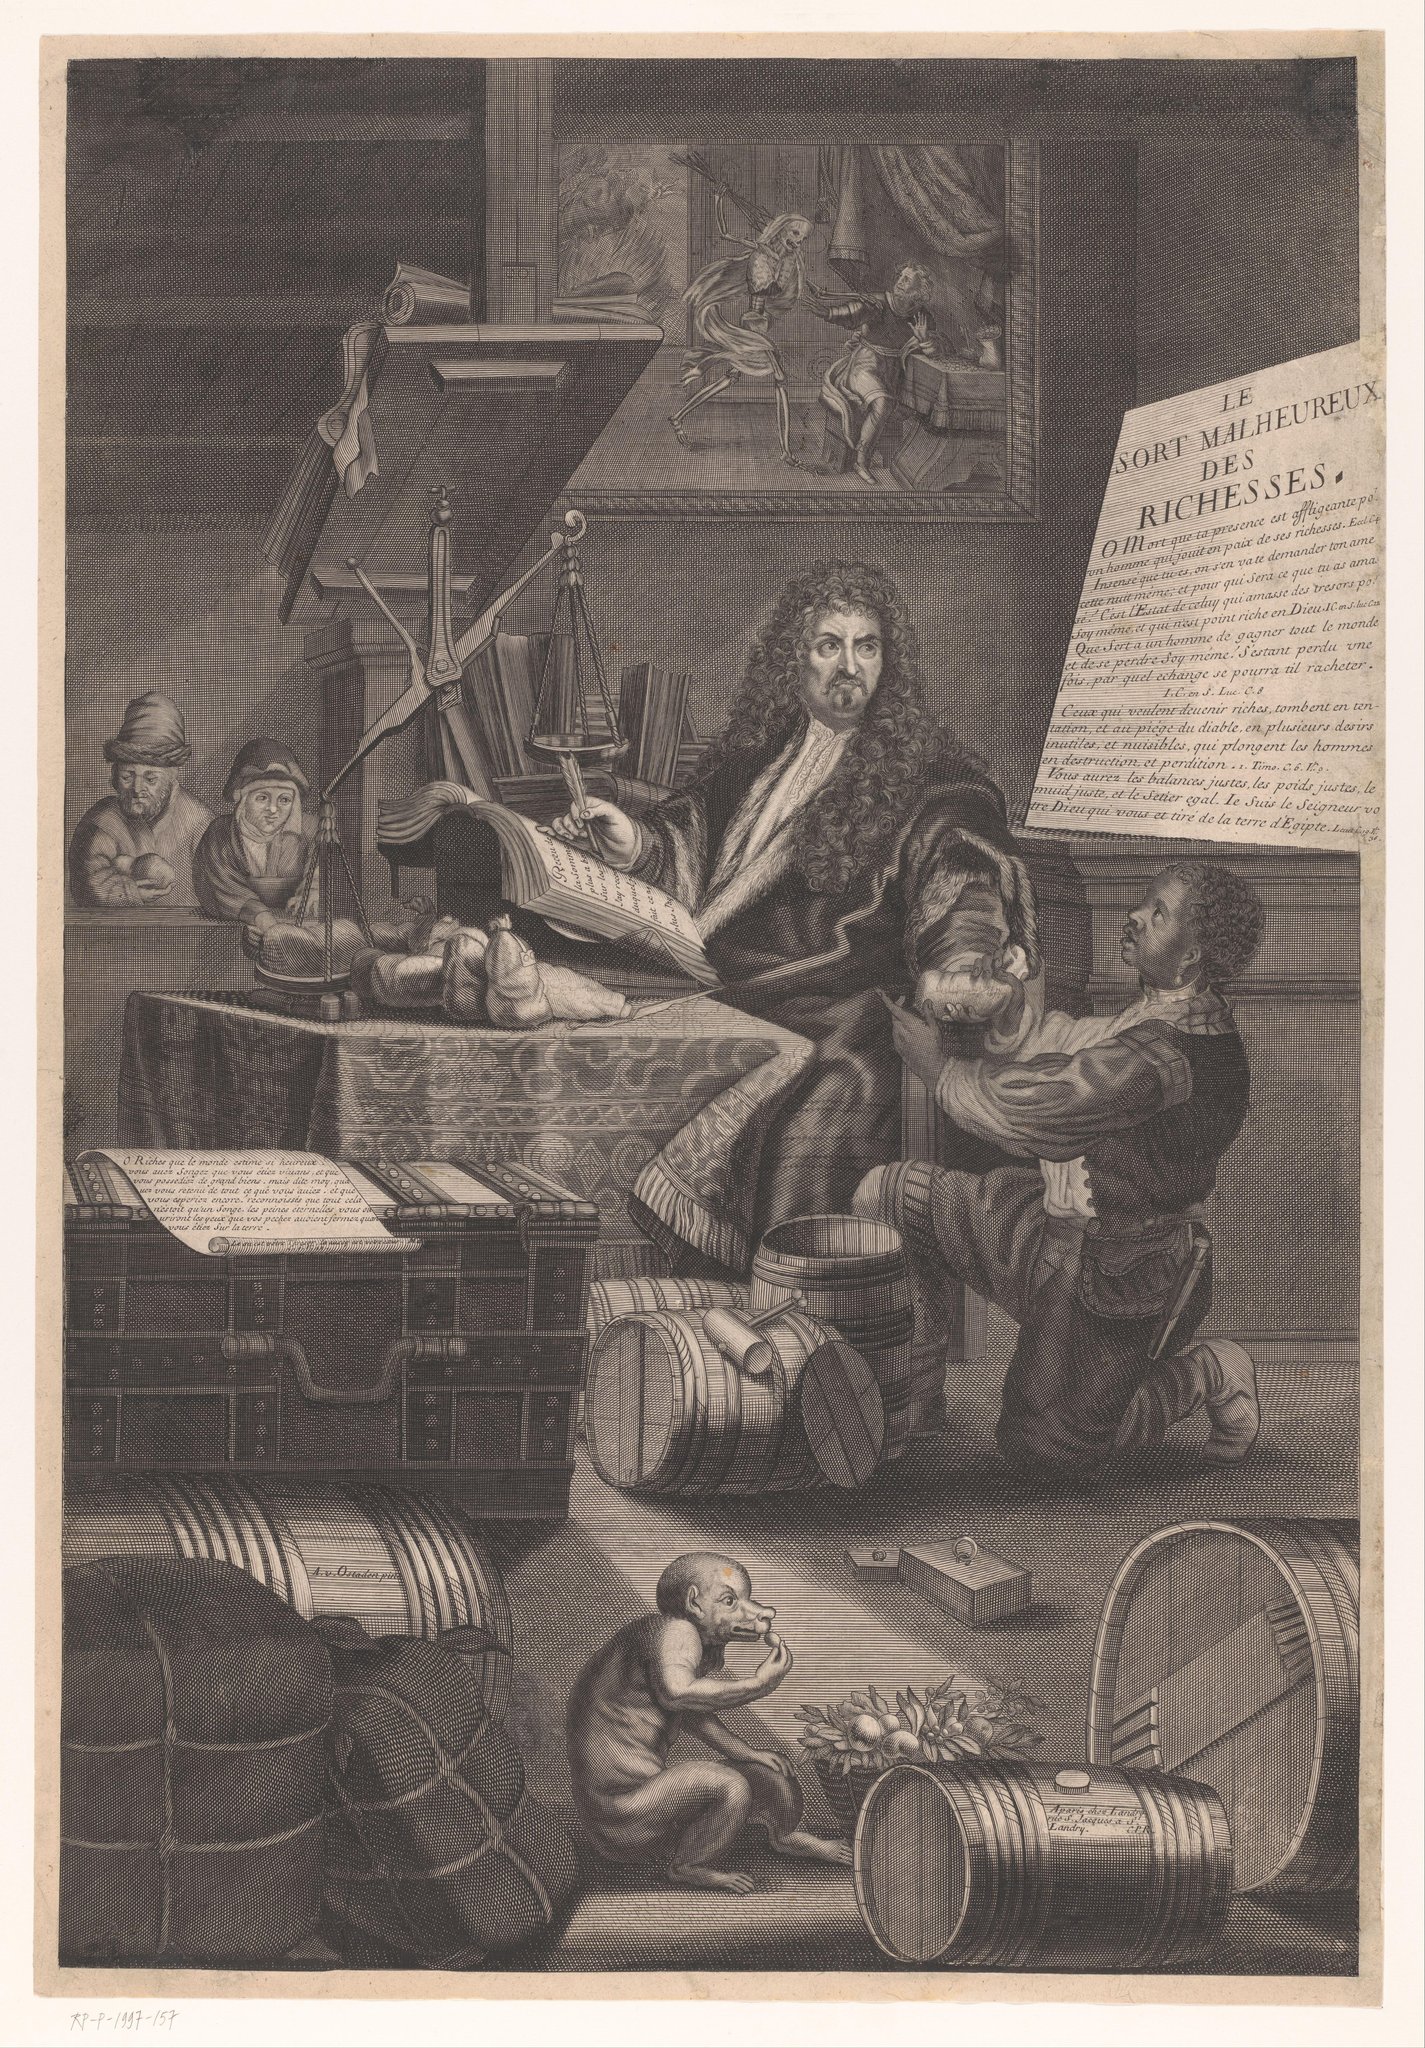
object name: print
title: Goudweger met bediende met waarschuwingen over de gevaren van rijkdom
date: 1639-1701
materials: paper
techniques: engraving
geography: france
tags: contemplating one's own riches, weighing gold or money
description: Allegorie op de valkuilen van rijkdom. In een kamer zit een schrijvende man met balans en zakken goud voor zich op tafel. Een bediende knielt voor hem. De compositie is gebaseerd op "De goudweger" van Rembrandt (B.281). Op de plaats waar bij Rembrandt een schilderij met de voorstelling van de koperen slang hangt, is hier een schilderij te zien waarop een rijke man wordt verrast door de dood.